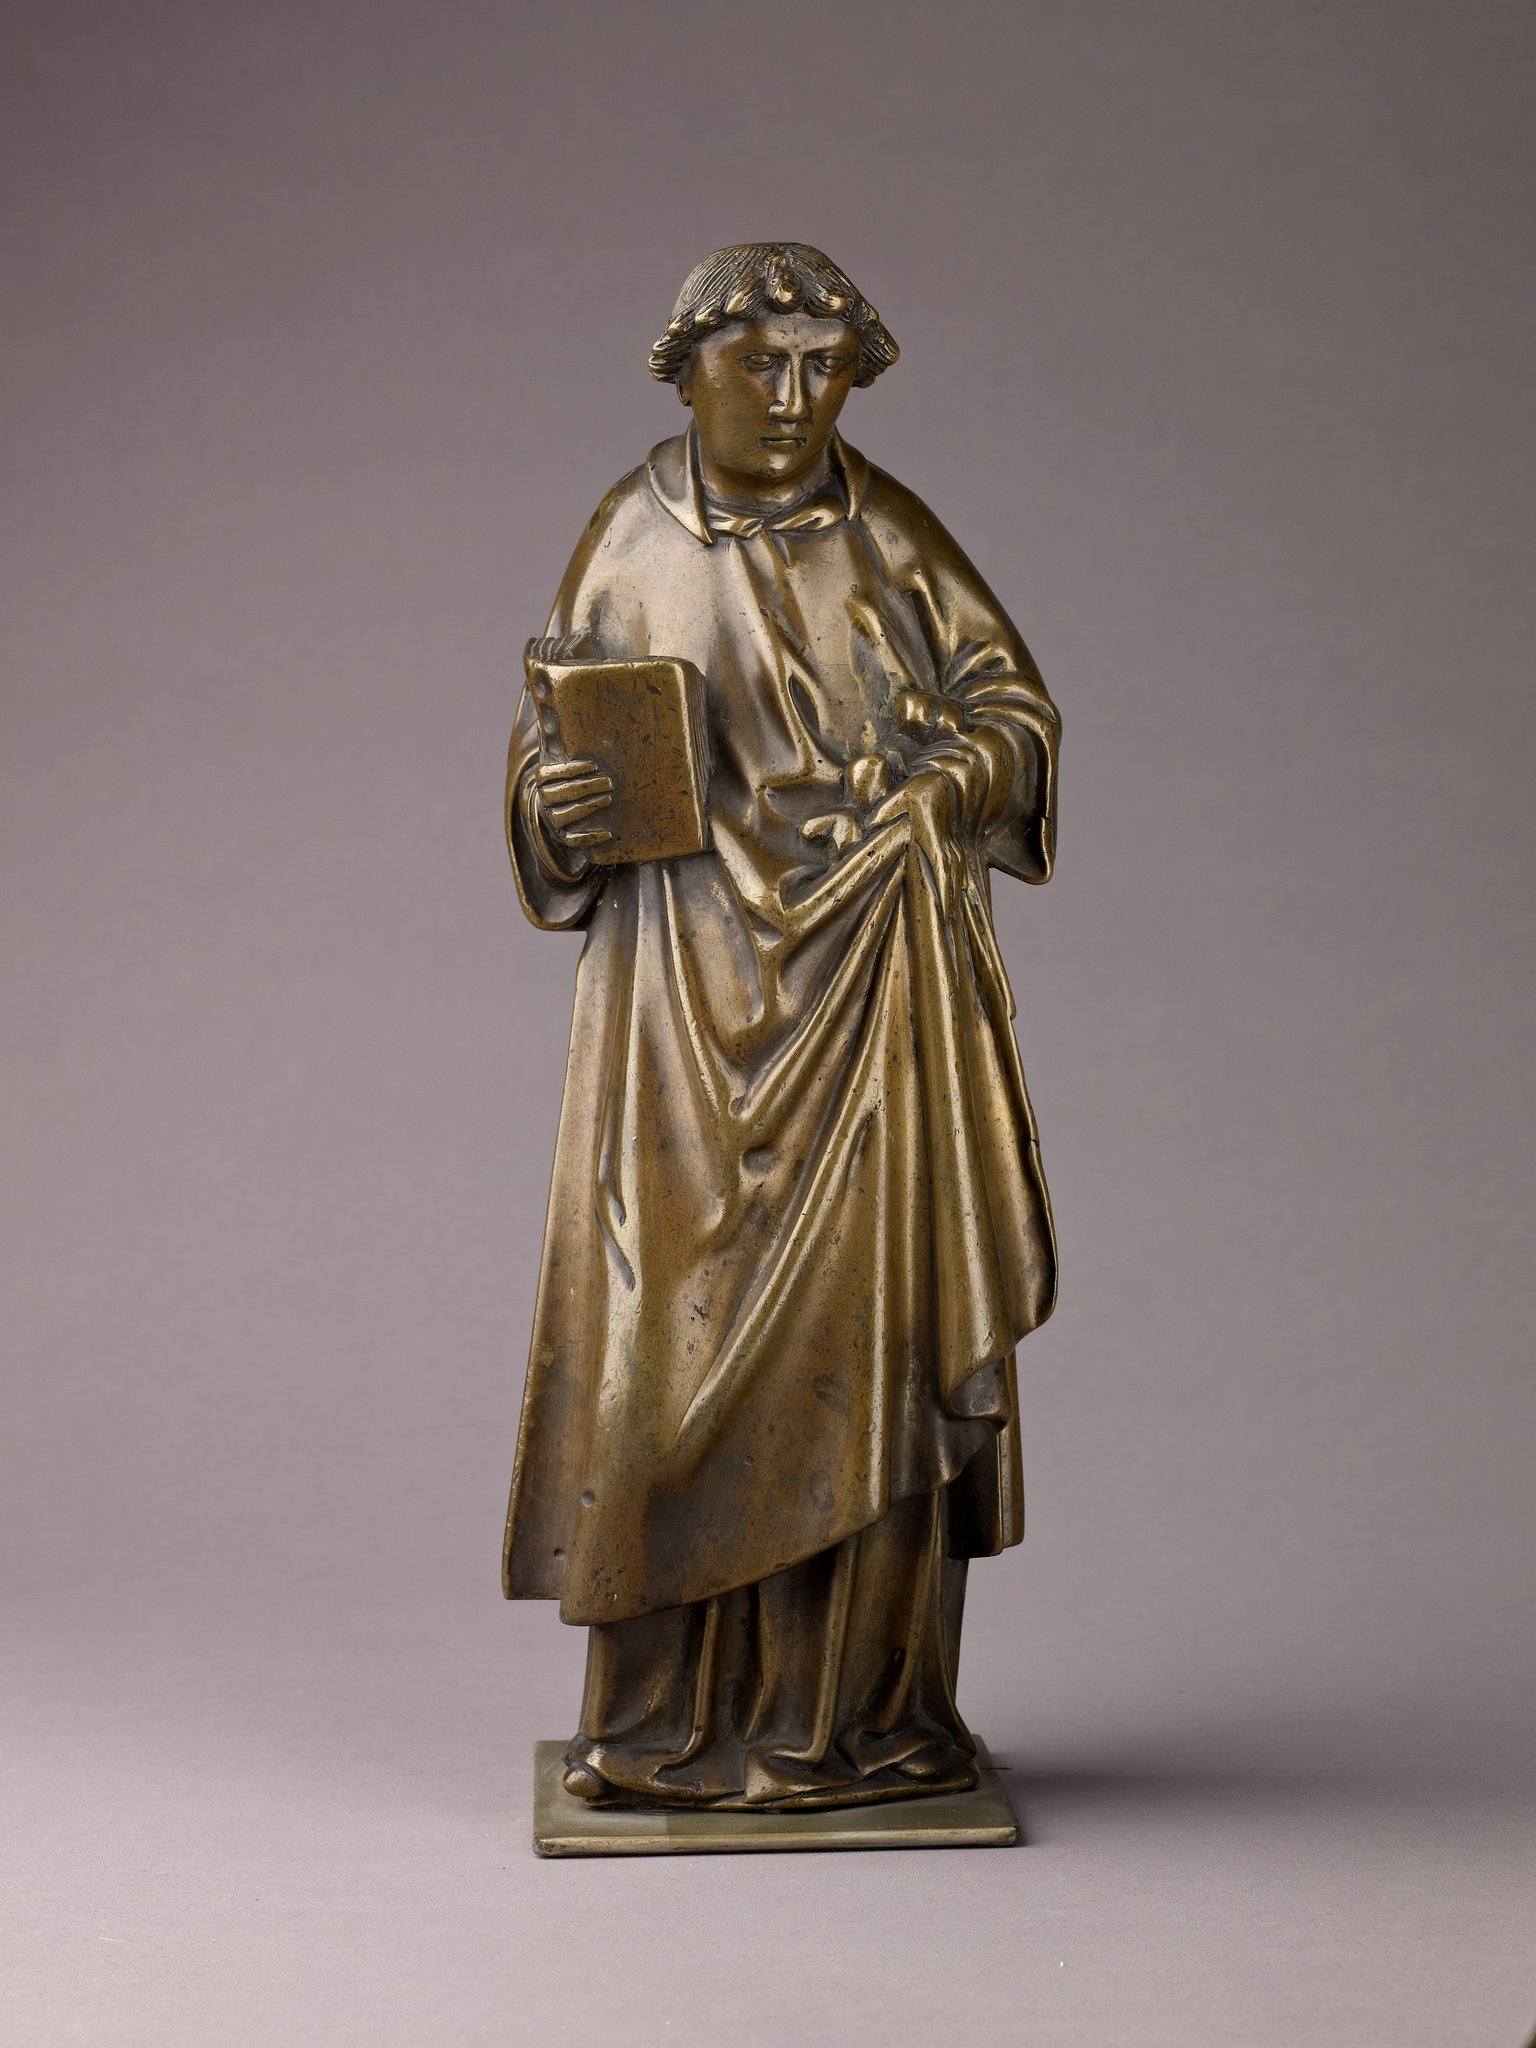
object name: sculpture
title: Saint Stephen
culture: dutch, tournai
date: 1451-1475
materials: brass, copper alloy, patina, zinc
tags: men,saints